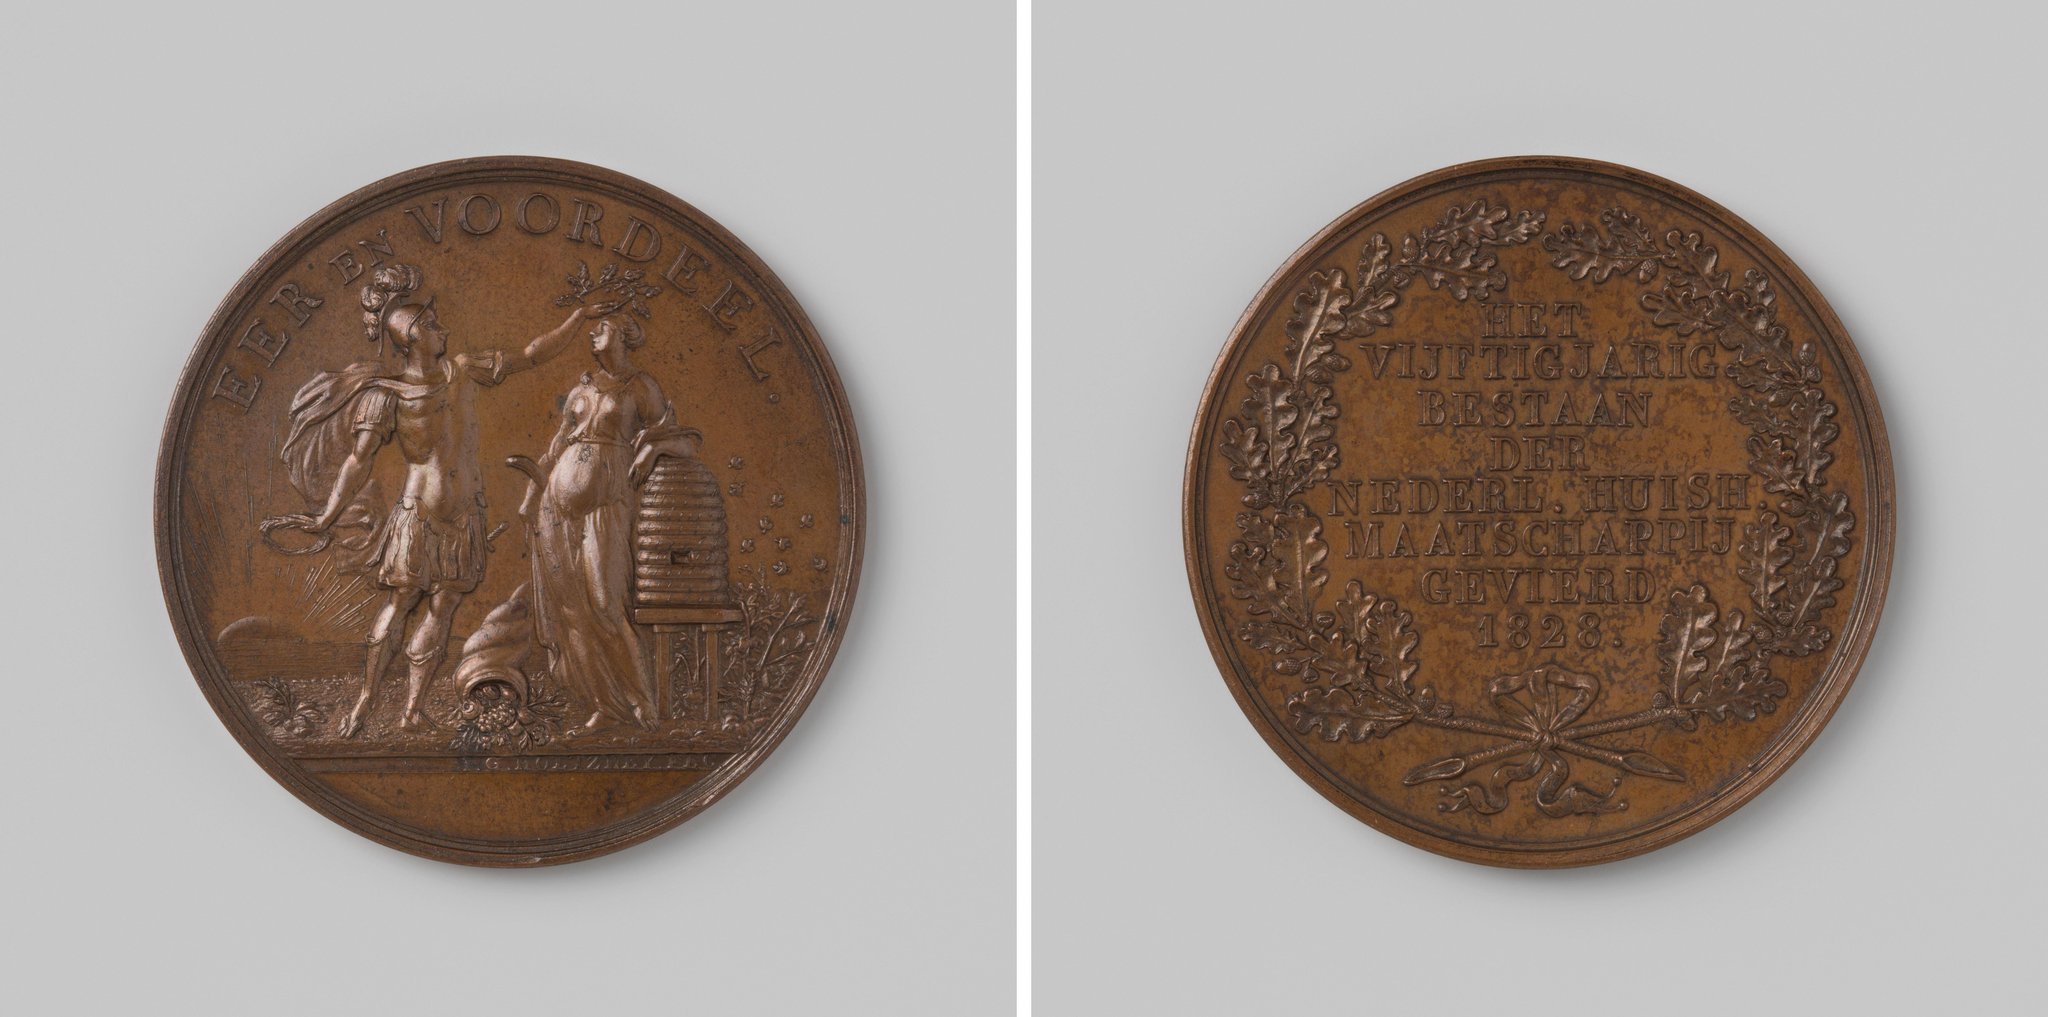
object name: history medal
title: Vijftigjarig bestaan van de Nationale Nederlandsche Huishoudelijke Maatschappij, voorheen de Oeconomische Tak van de Hollandsche Maatschappij der Wetenschappen te Haarlem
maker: johan george holtzhey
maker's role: mintmaster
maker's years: 1726-1808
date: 1804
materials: bronze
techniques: striking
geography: amsterdam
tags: haarlem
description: Bronzen penning. Voorzijde: man in Romeinse kledij, voorstellende Vaderlandsliefde, houdt in zijn rechterhand een lauwerkrans en zet met zijn andere hand eikenkrans op hoofd van Nijverheid, die hoorn van overvloed in handen houdt en tegen bijenkorf leunt; op achtergrond opgaande zon binnen omschrift. Keerzijde: opschrift binnen eikekrans